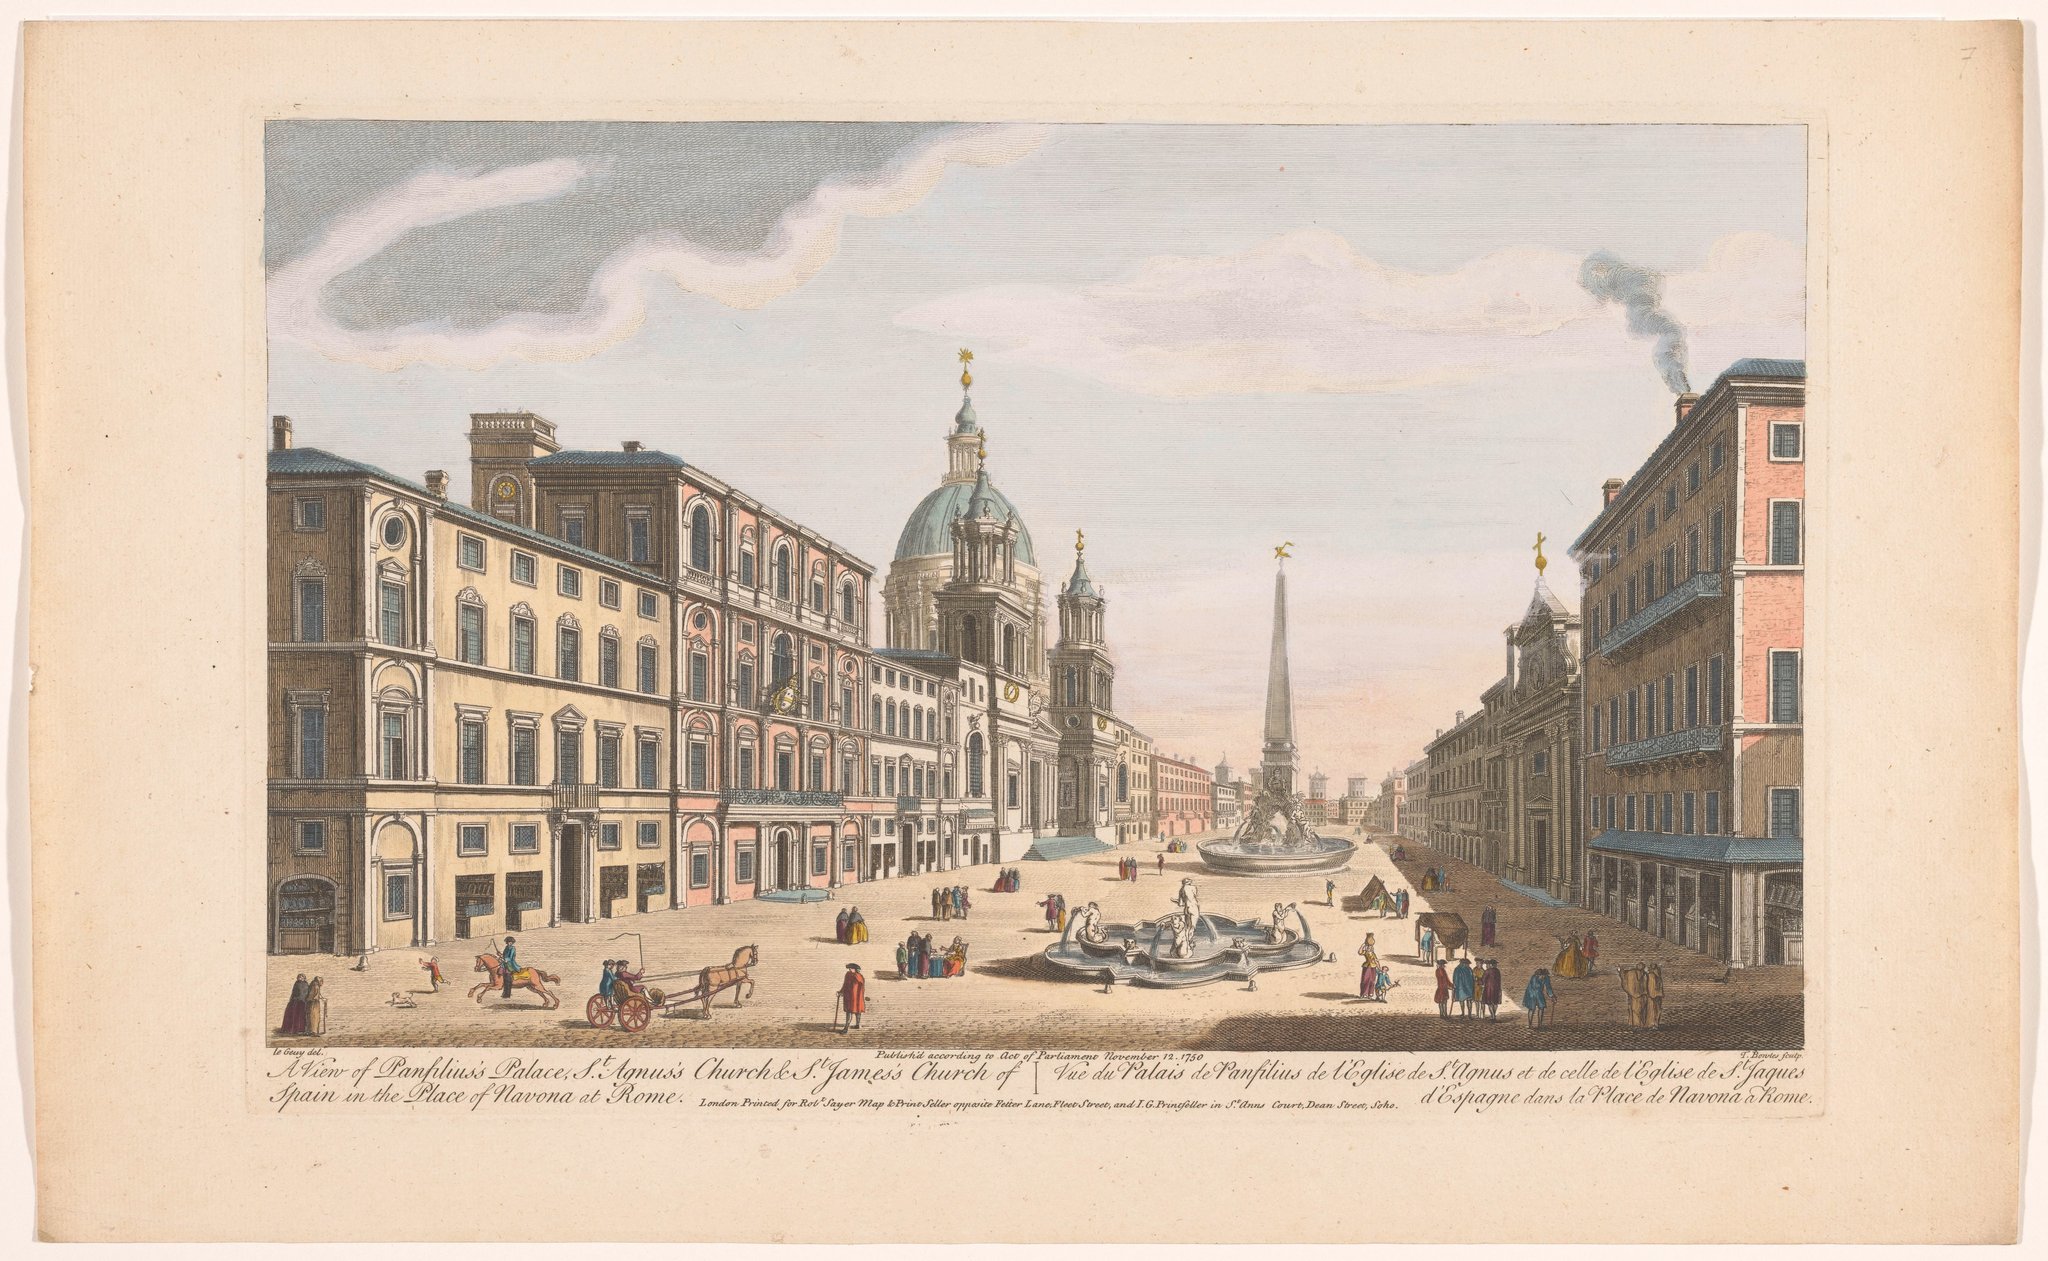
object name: print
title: Gezicht op het Palazzo Pamphili en het Piazza Navona te Rome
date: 1750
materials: paper, watercolor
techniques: brush, etching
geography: london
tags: obelisk, needle (+ city(-scape) with figures, staffage), palace, church (exterior), square, place, circus, etc. (+ city(-scape) with figures, staffage), ornamental fountain (+ city(-scape) with figures, staffage)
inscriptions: watermark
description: De serie “Rome” bevat twaalf prenten met de nummers 1-12, waarvan dit nummer 7 is.